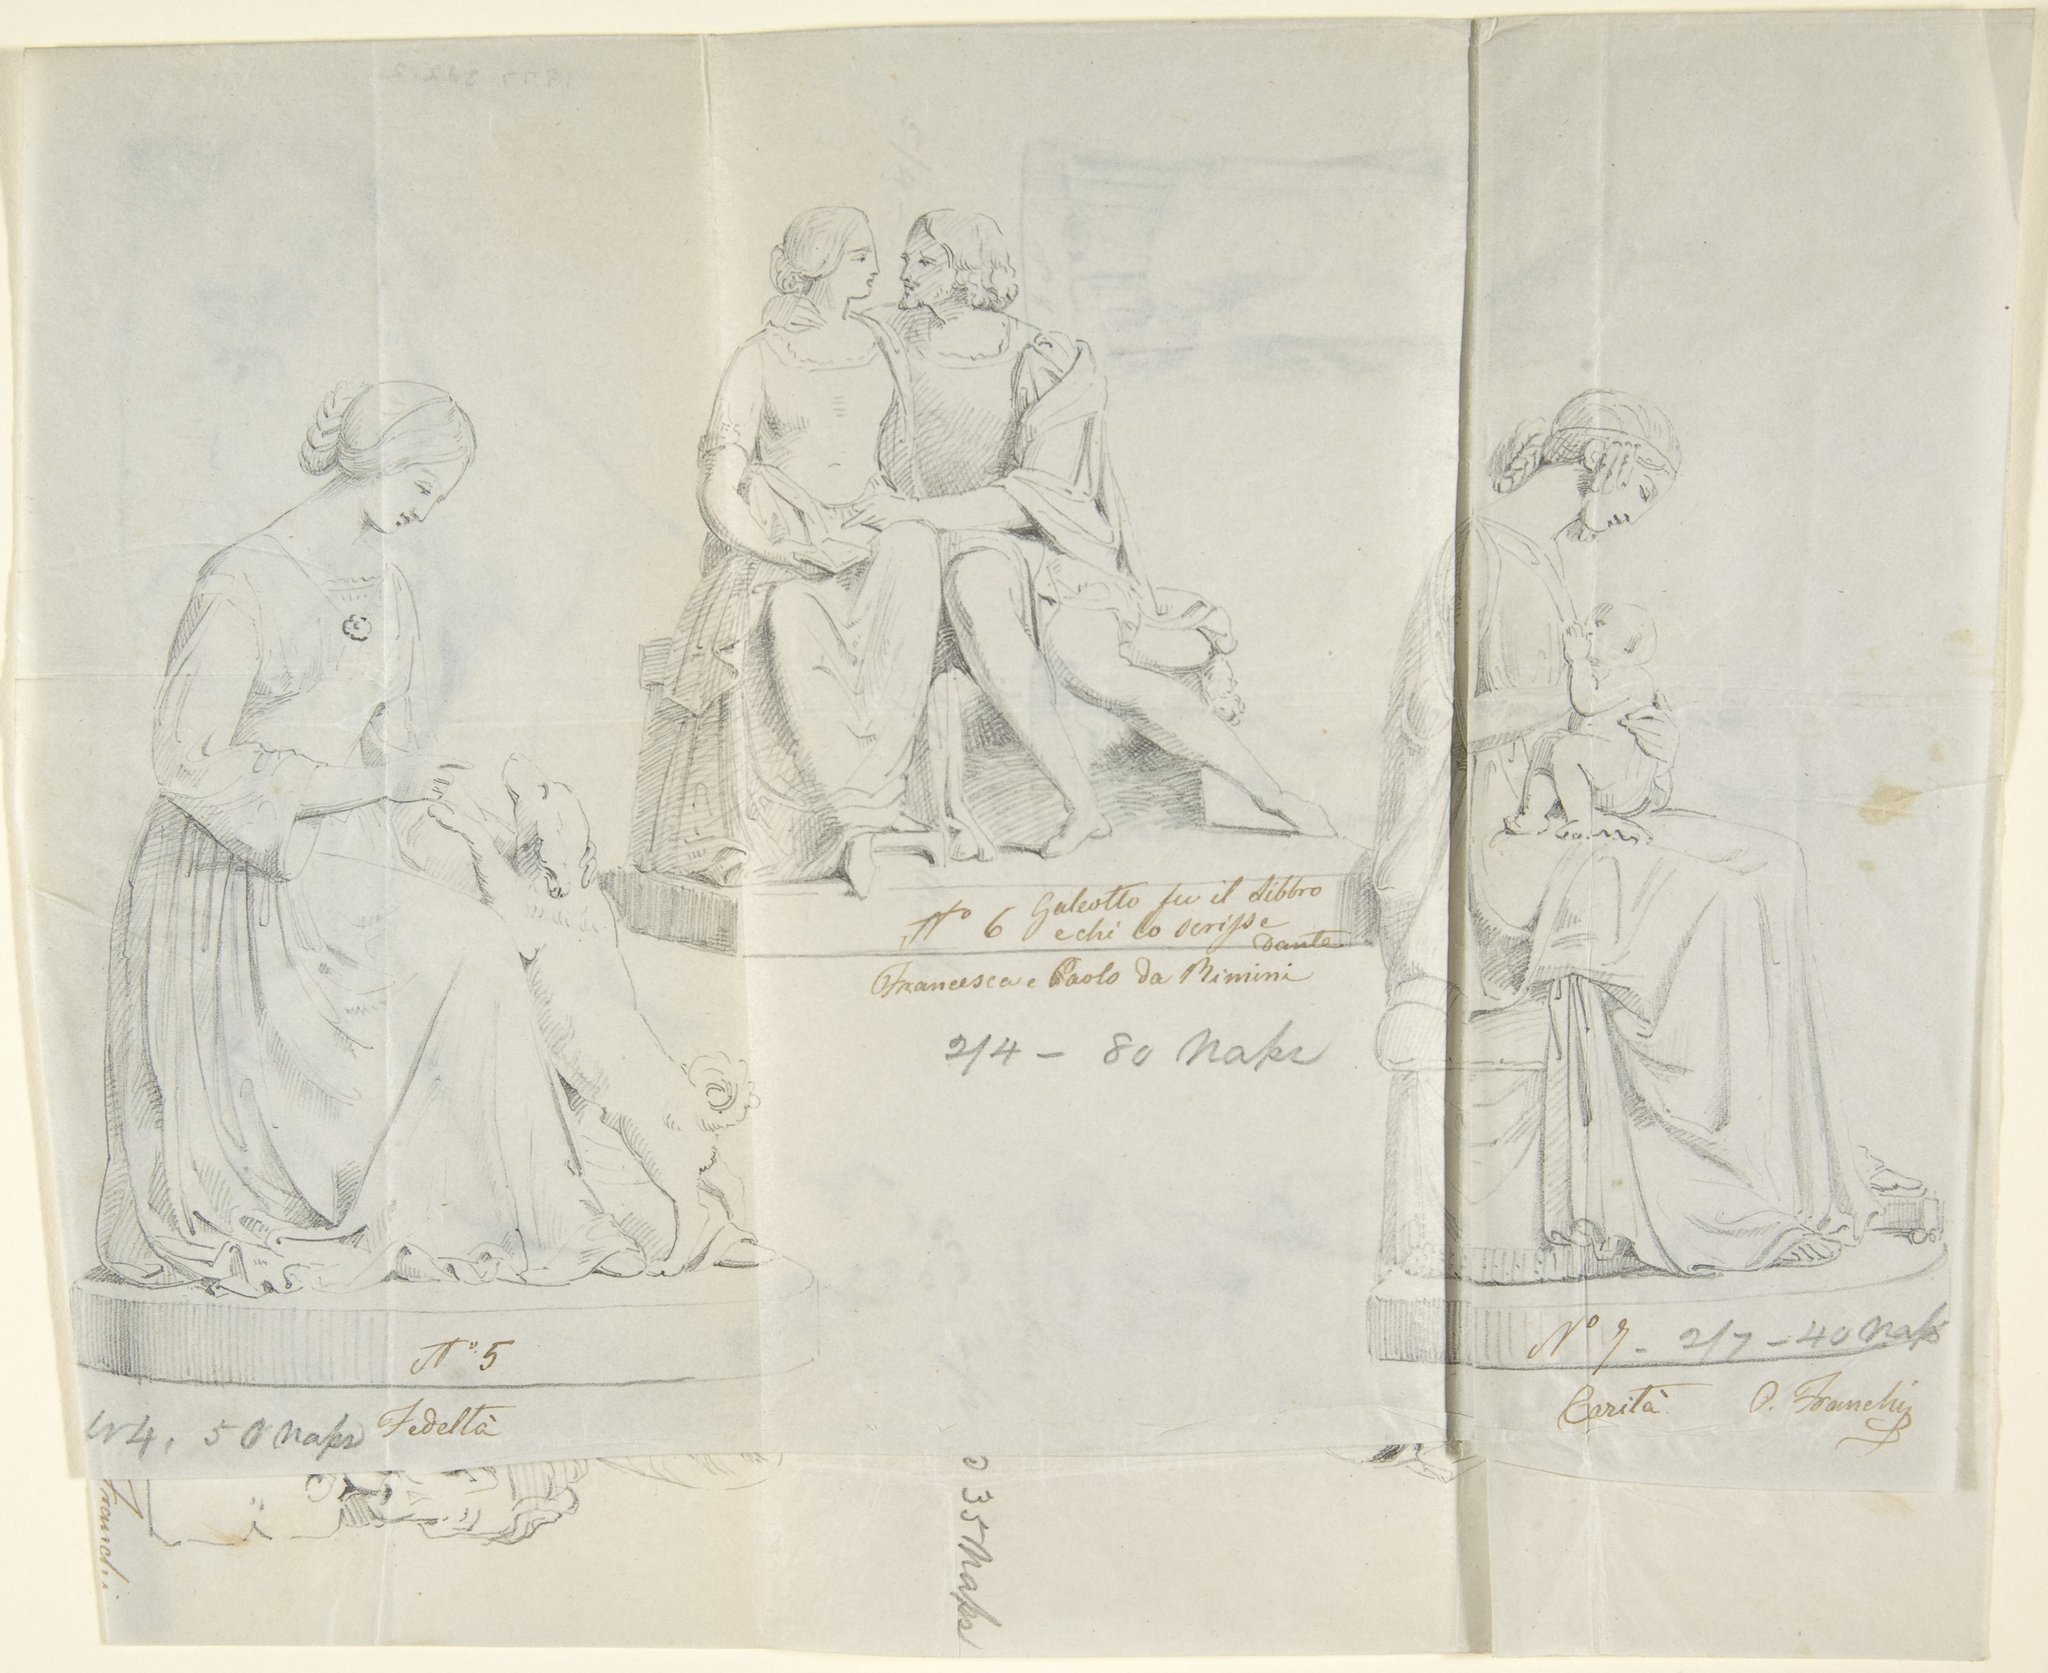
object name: drawing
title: Sketches of seven statues: Faith, Paolo and Francesca di RImini, Charity, Ceres, Heavenly Venus, Dancer, and Sleeping Cupid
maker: john gibson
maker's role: artist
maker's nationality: british, born wales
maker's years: 1790-1866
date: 1850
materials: graphite, ink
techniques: pen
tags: infants,men,women,dogs